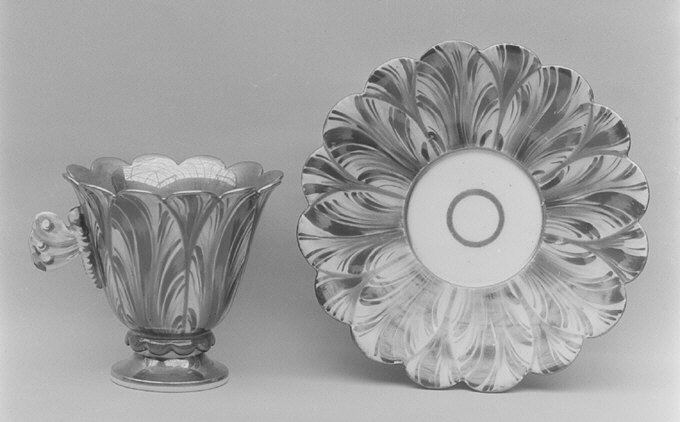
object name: cup and saucer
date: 1801-1900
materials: hard paste porcelain